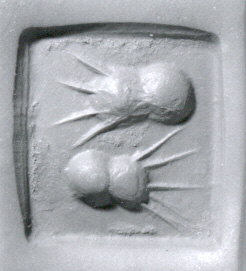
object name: stamp seal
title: Drilled square plaque seal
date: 3500-2900 BCE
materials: marble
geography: iran or mesopotamia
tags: insects